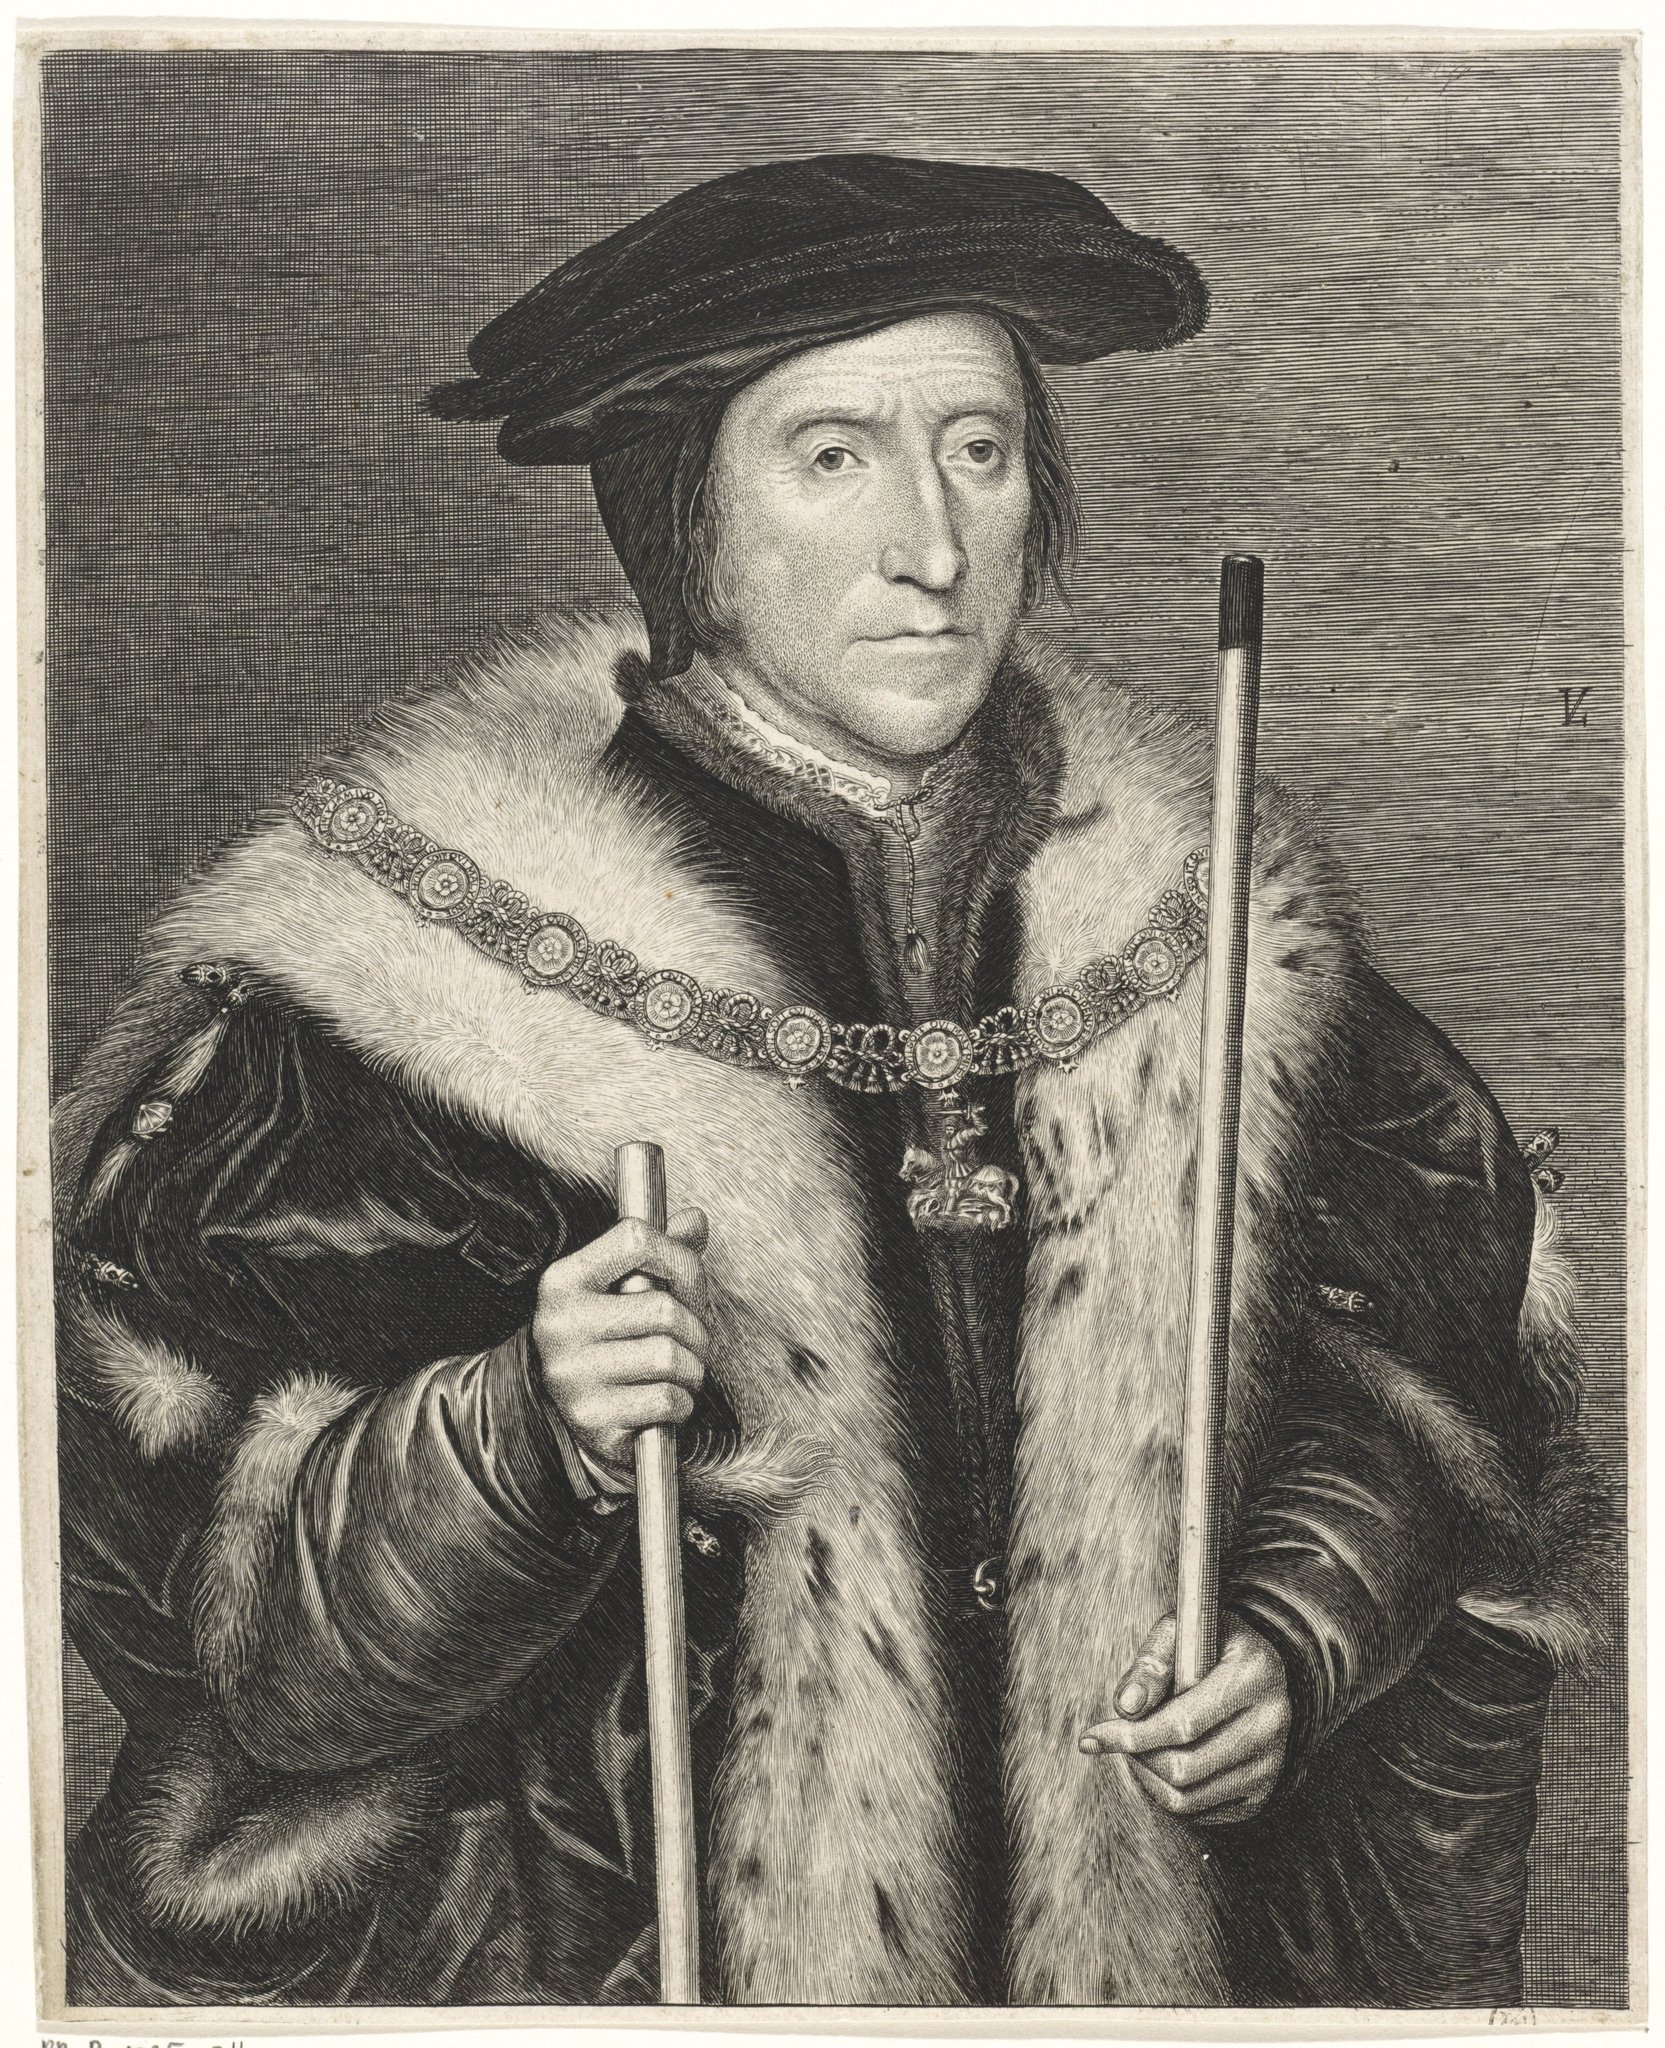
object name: print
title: Portret van Thomas Howard, graaf van Norfolk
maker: lucas vorsterman (i)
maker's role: print maker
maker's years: 1595-1675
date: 1624-1630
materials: paper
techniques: engraving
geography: england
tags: politician, knighthood order (garter)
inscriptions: collector's mark: Lugt 2228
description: Portret van de Engelse staatsman Thomas Howard, graaf van Norfolk. Om zijn hals het teken van de Orde van de Kousenband.